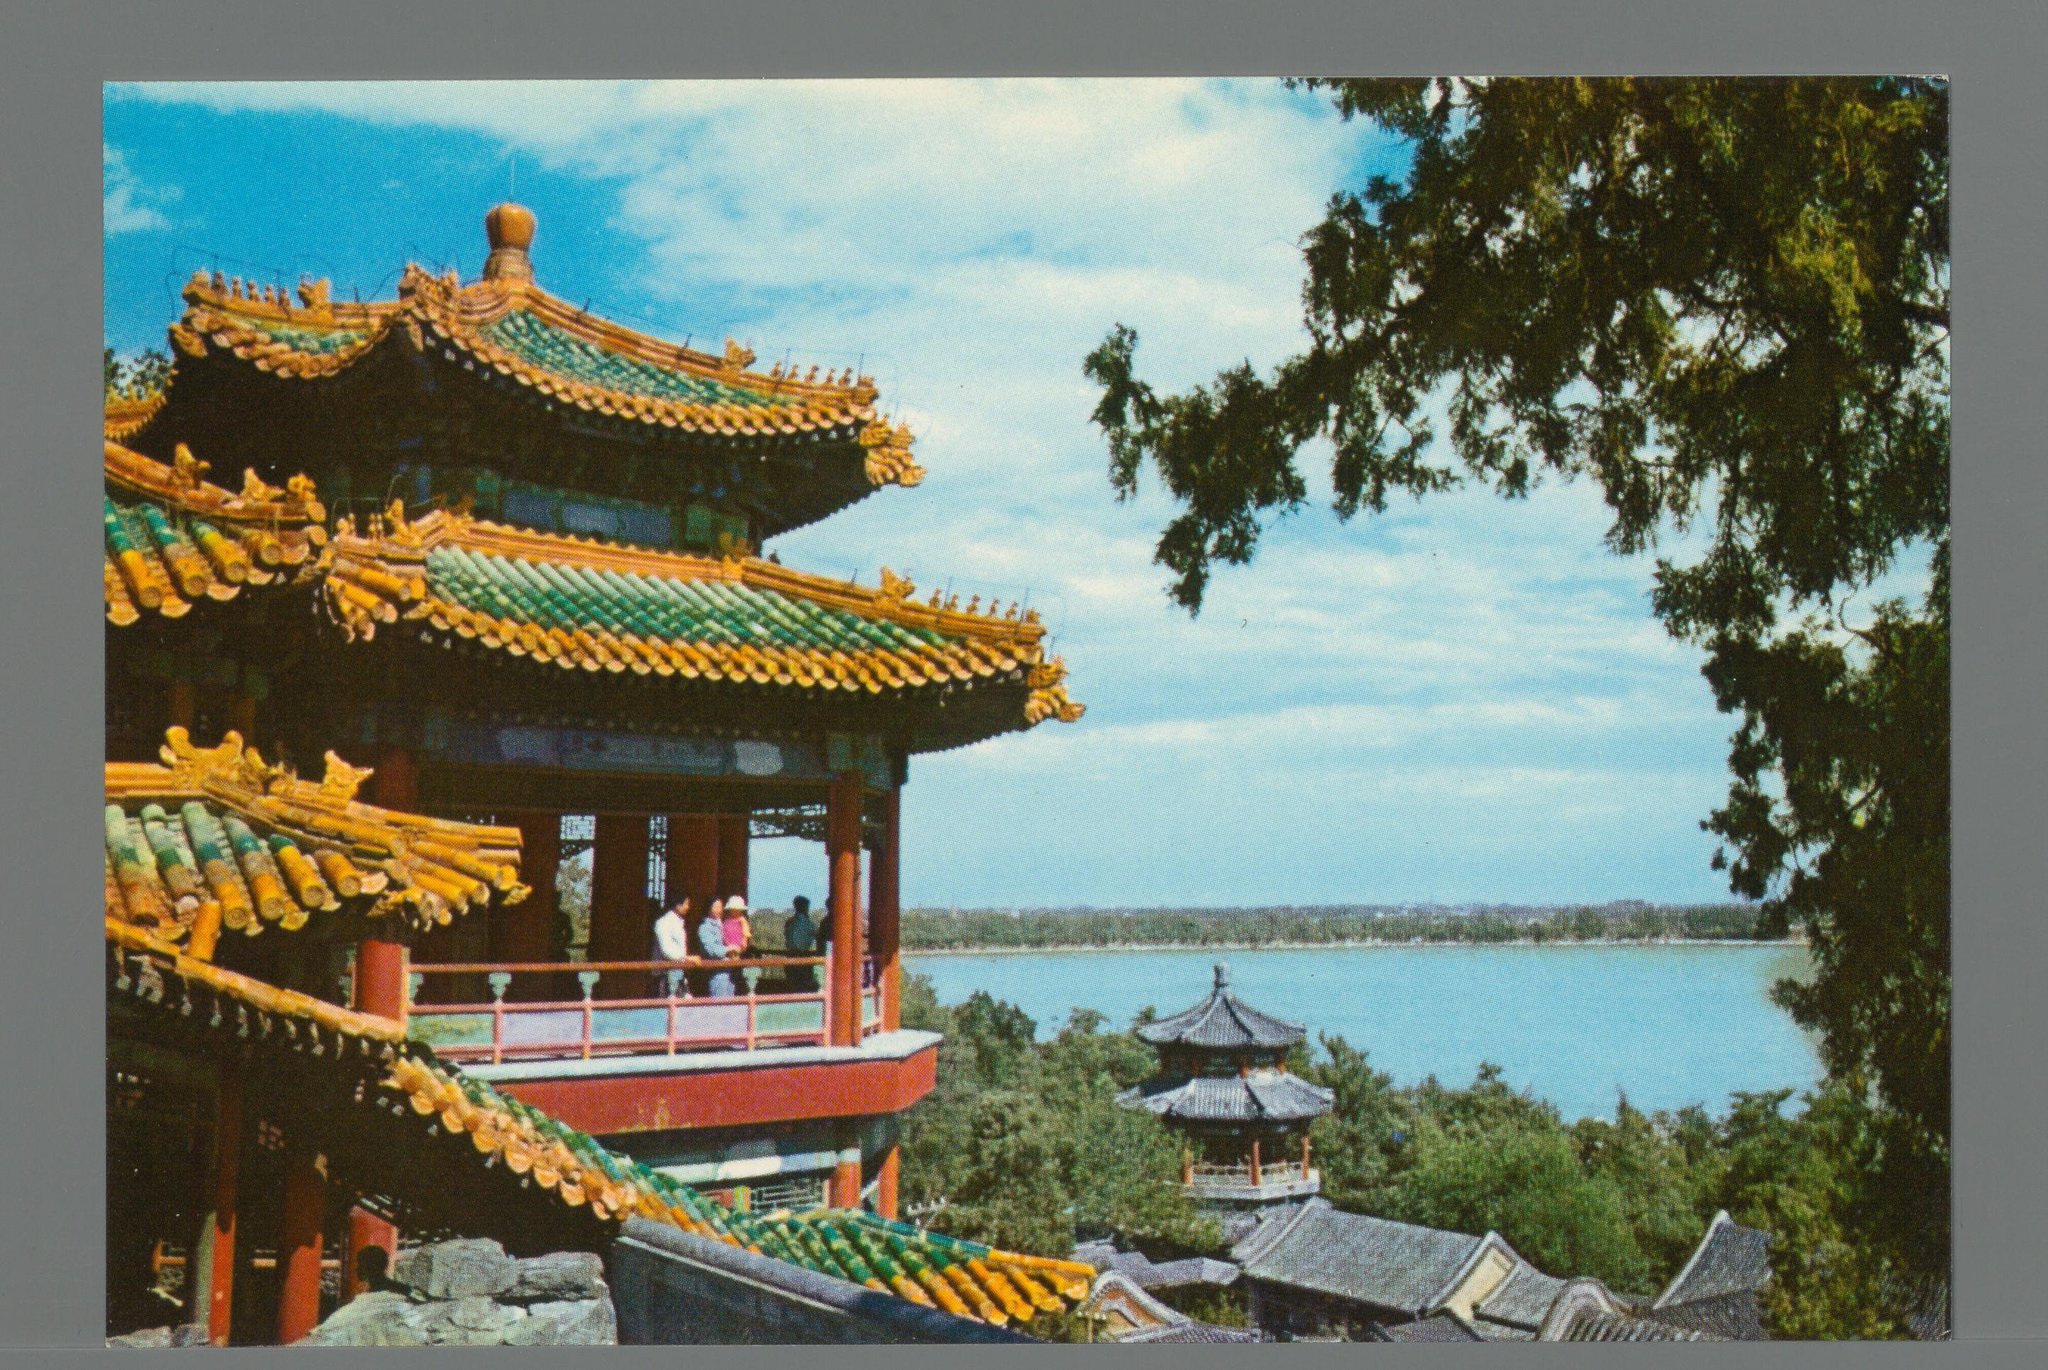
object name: ansichtkaart, prentbriefkaart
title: The Summer Palace, Peking / Vues du Palais d'Eté de Pékin / Vista del Palacio de Verano, Pekin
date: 1974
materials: cardboard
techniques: offset printed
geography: beijing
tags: palace, avenue, boulevard, promenade, esplanade